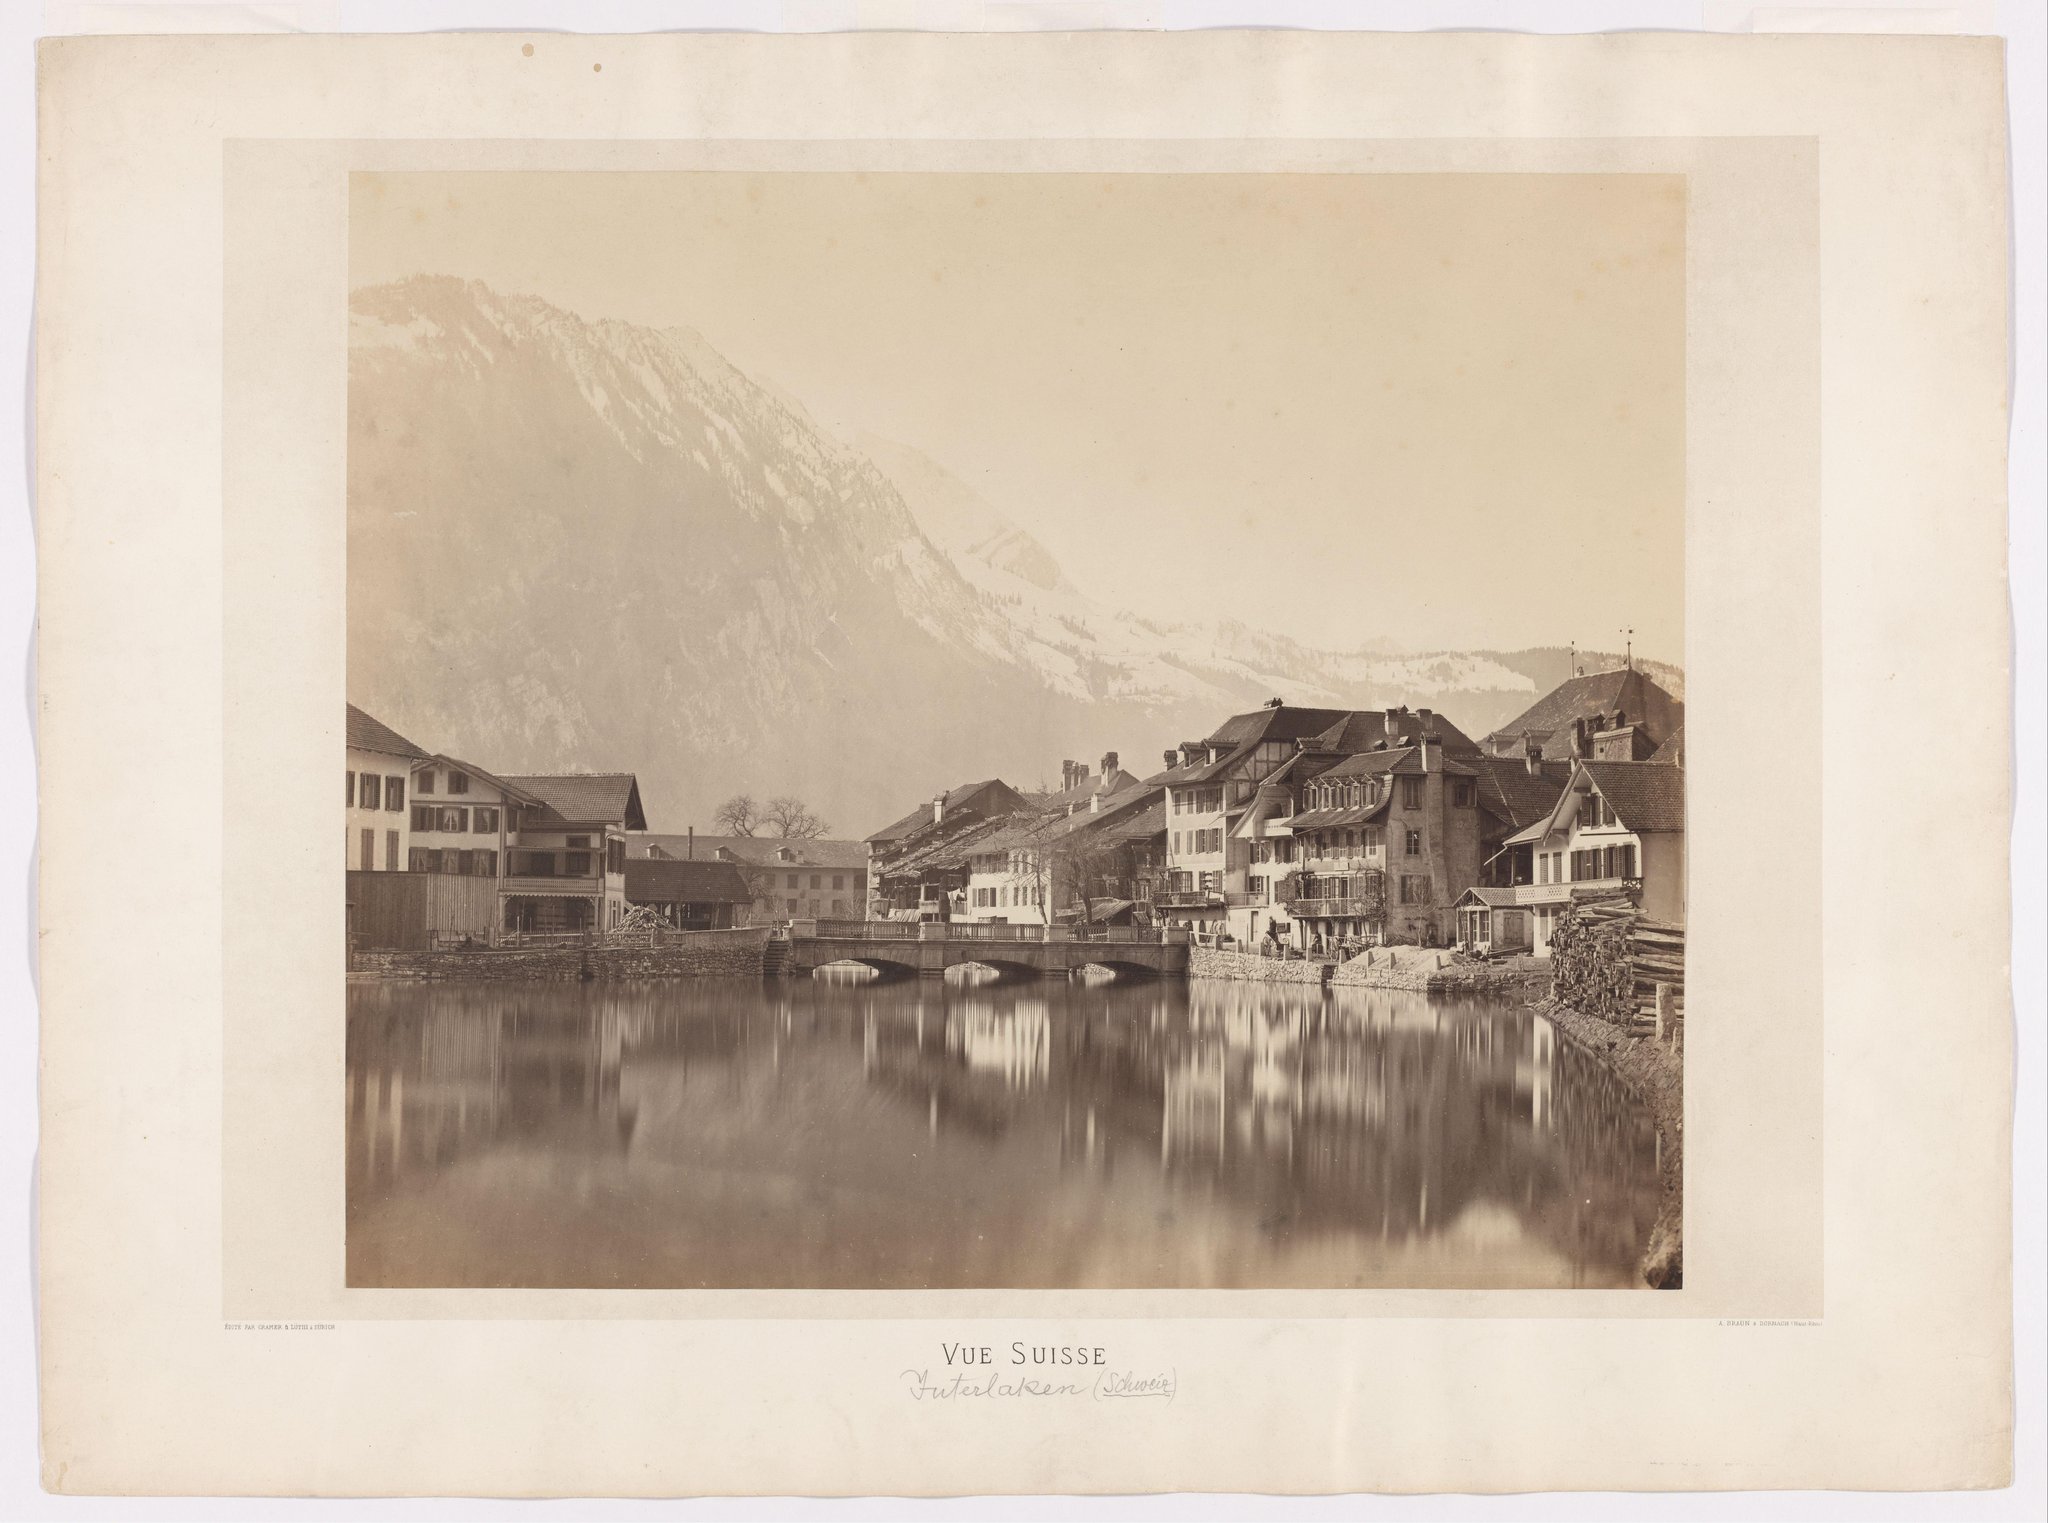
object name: photograph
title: Gezicht op Interlaken ('Vue Suisse')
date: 1858-1862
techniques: albumen print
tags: interlaken